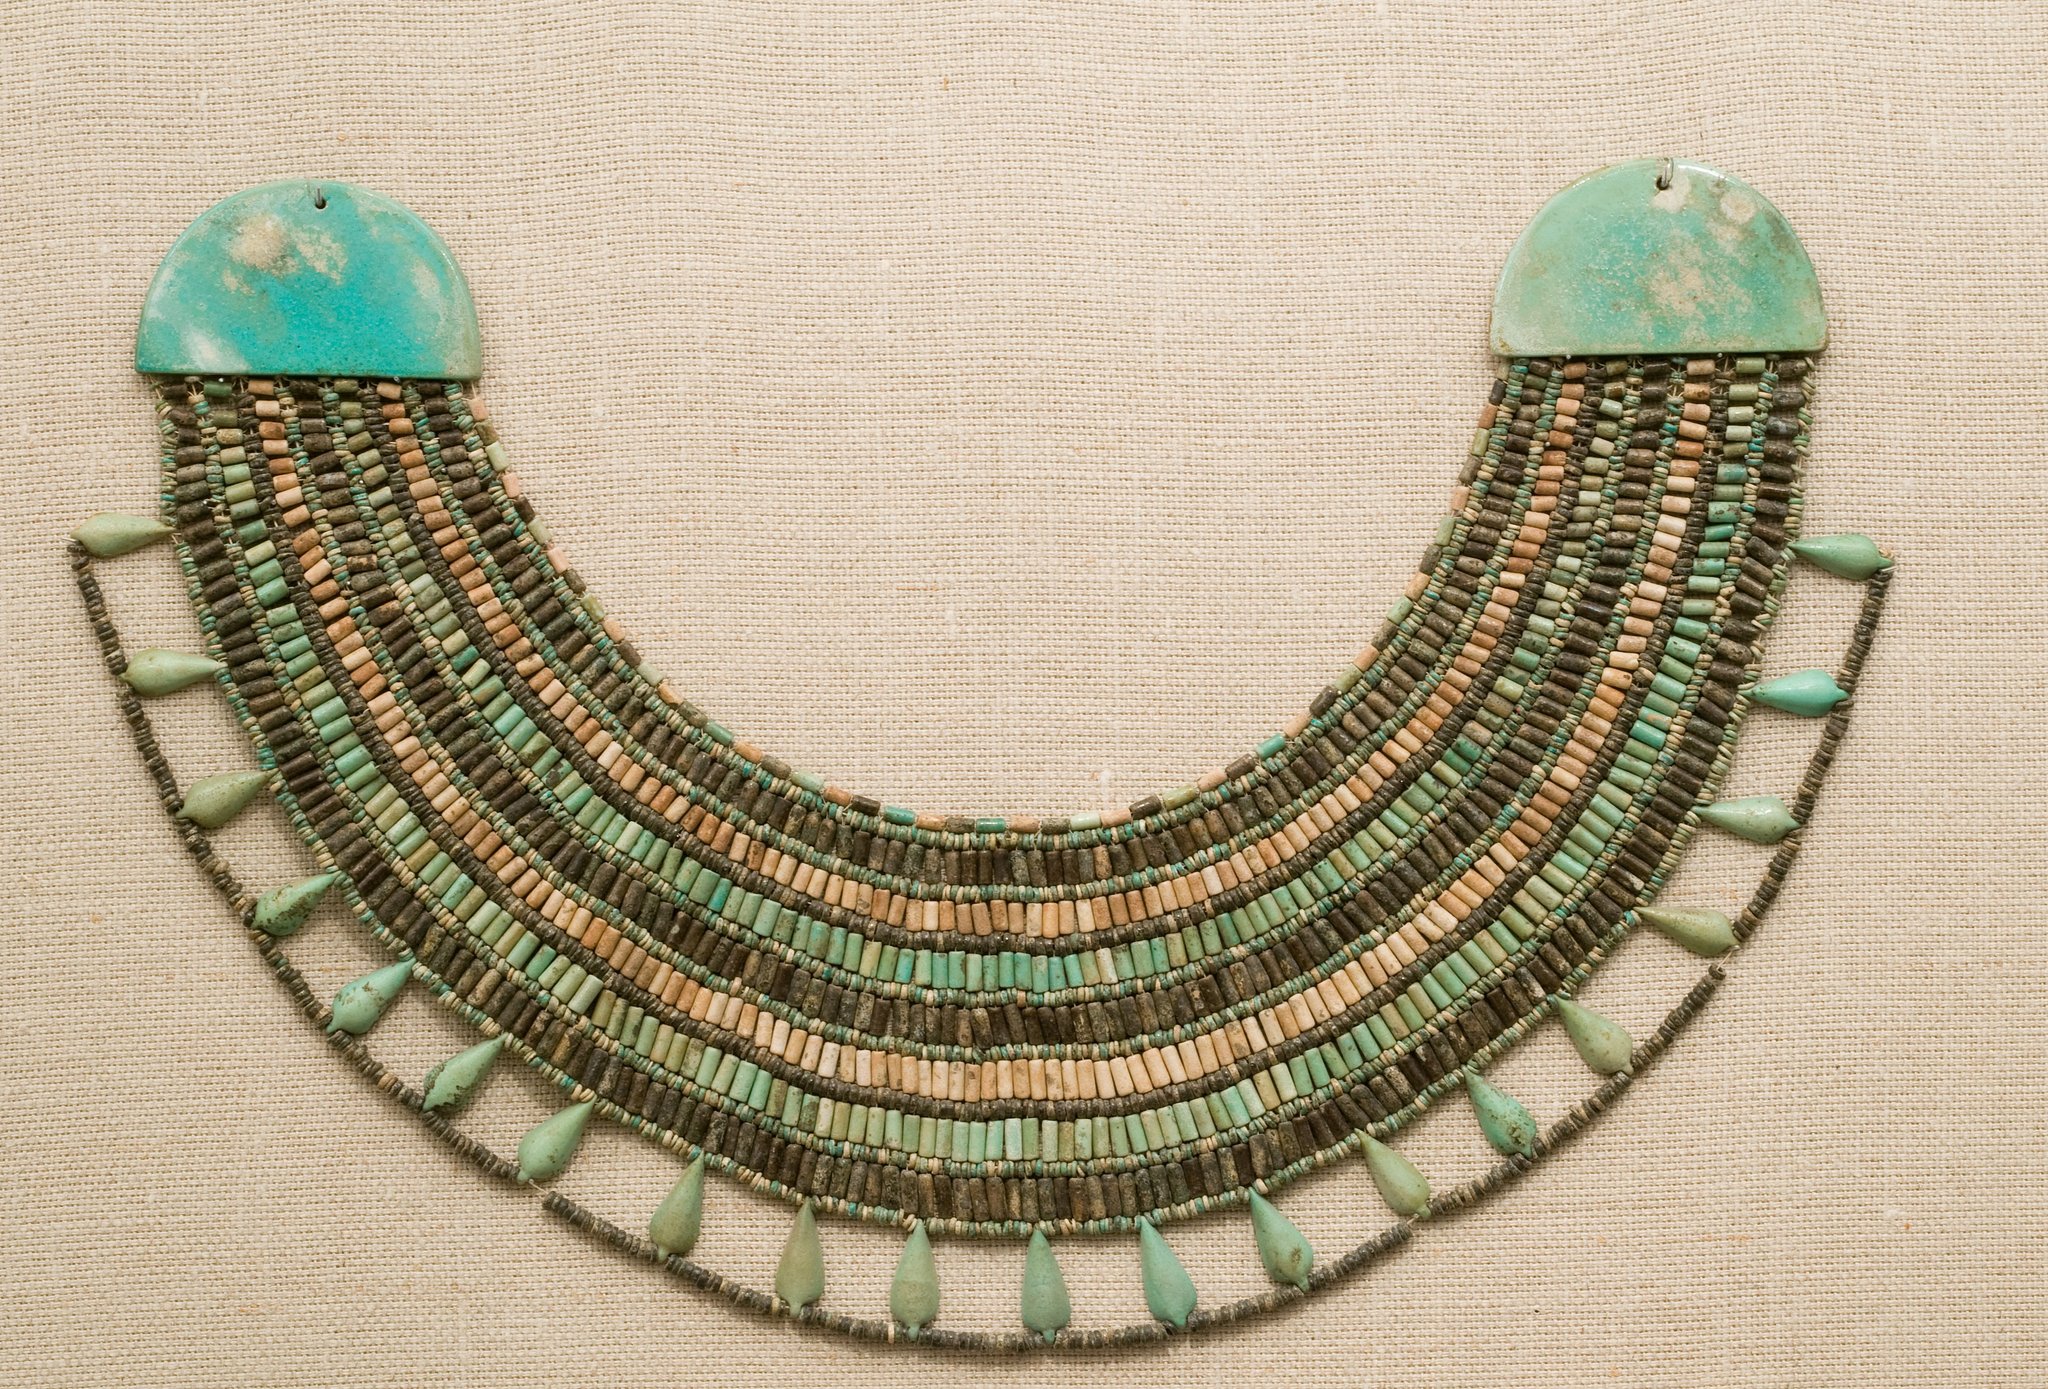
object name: broad collar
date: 1981-1640 BCE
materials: faience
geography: egypt